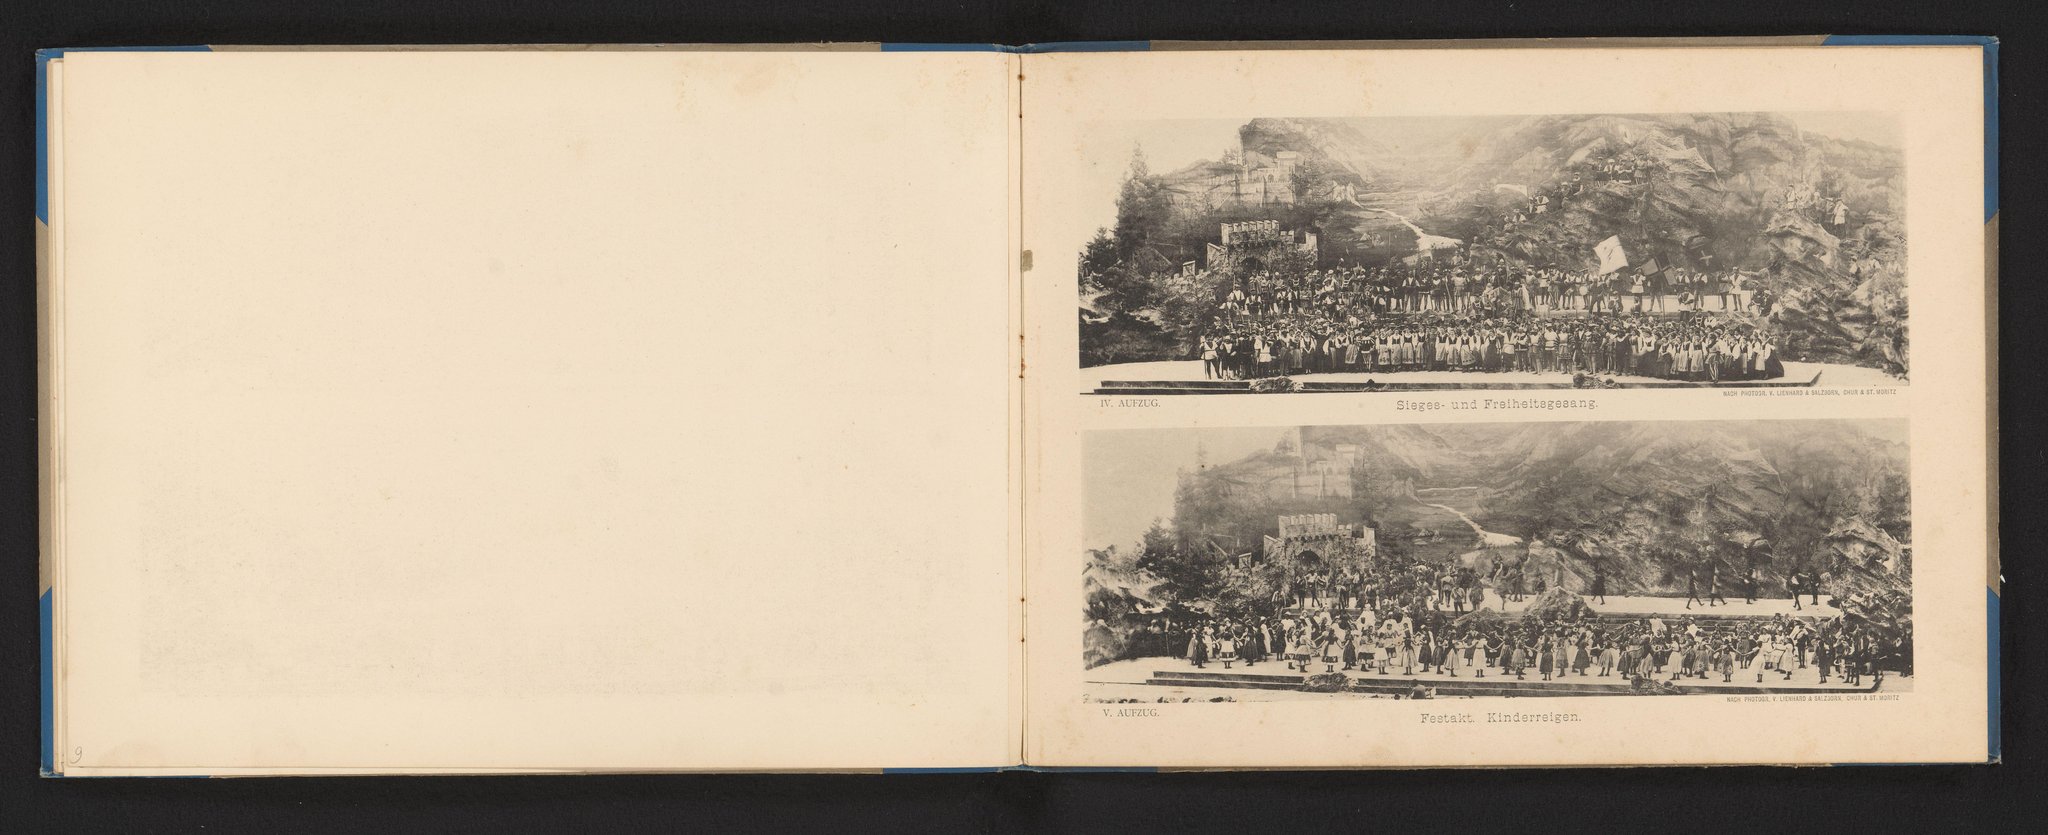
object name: photomechanical print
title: Festakt. Kinderreigen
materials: paper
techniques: photograph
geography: chur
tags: activities in the air ~ public festivities, e.g. fly-past, choir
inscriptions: number: ‘IV. V.’